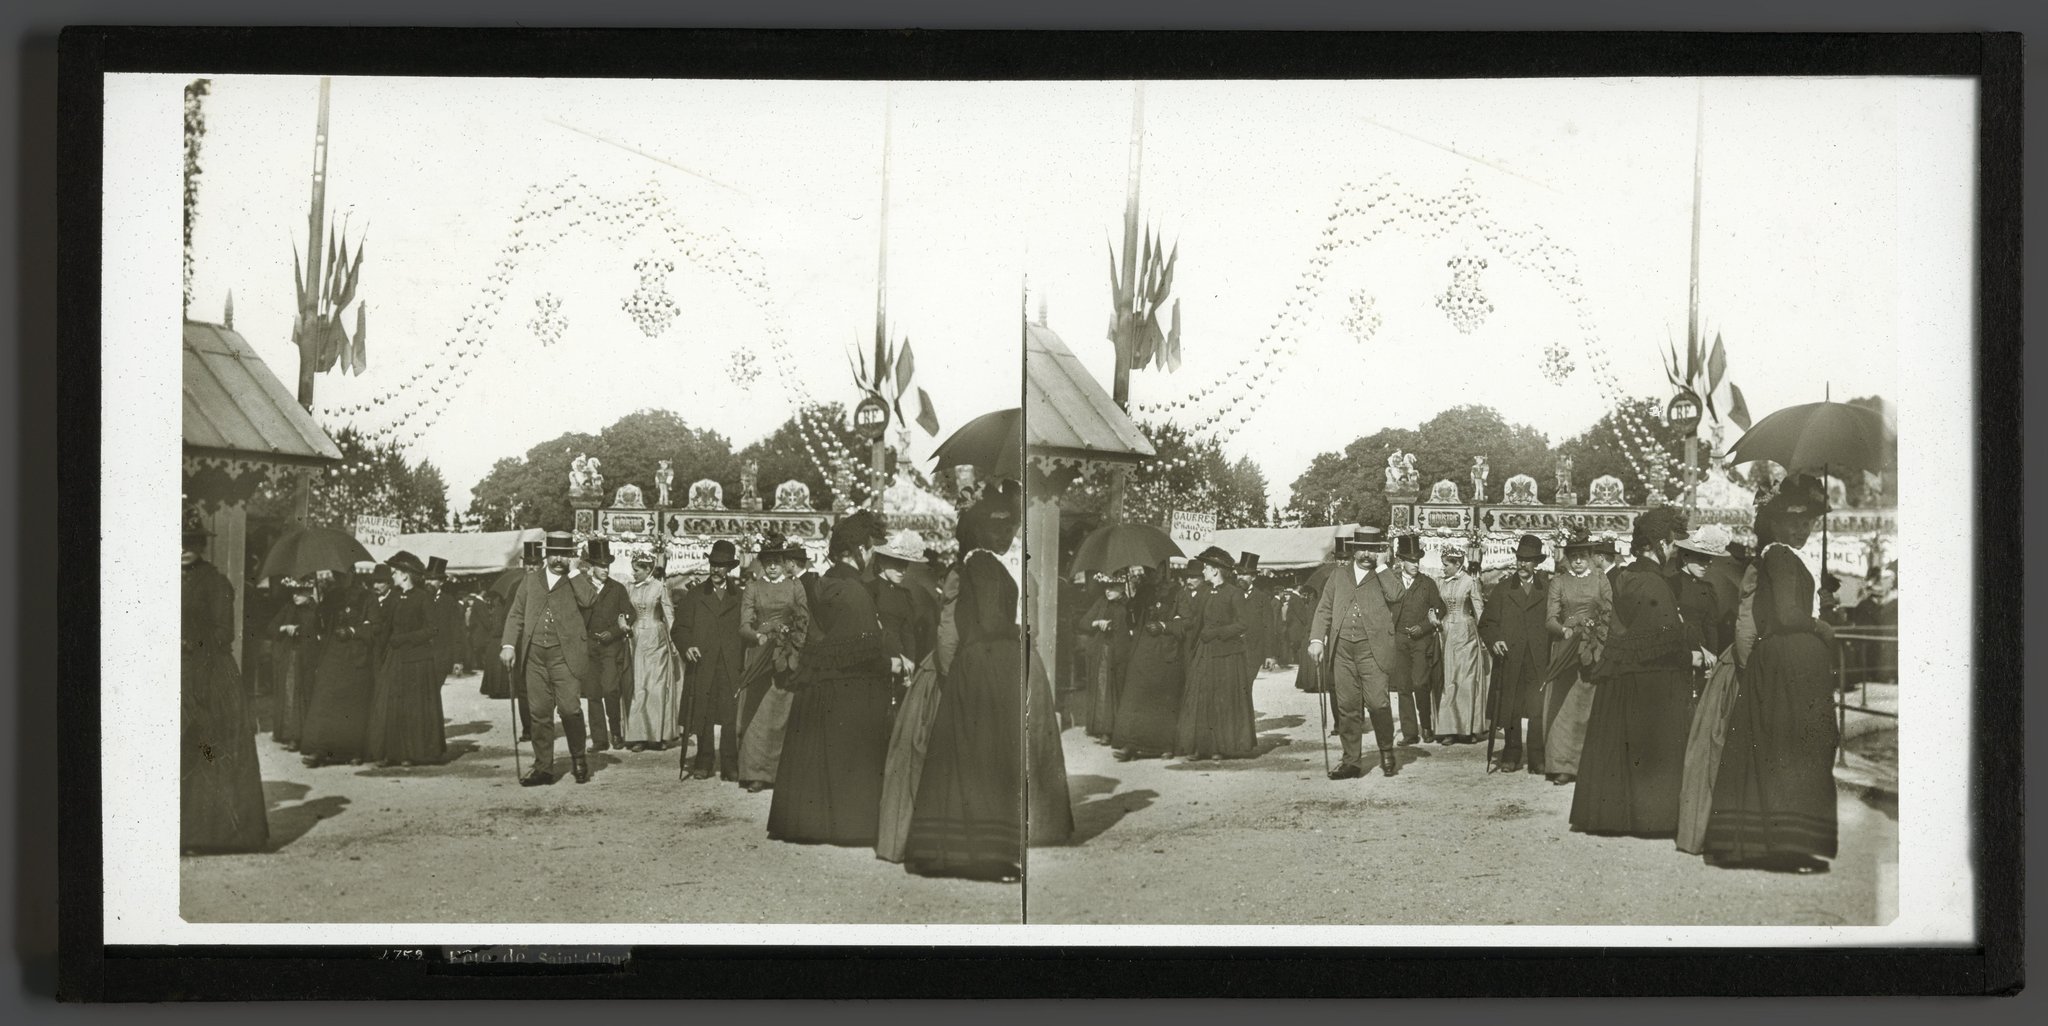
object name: stereoscopic photograph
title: Fête de Saint-Cloud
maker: Anonymous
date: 1860-1890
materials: glass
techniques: slide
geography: saint-cloud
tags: public festivities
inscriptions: number: ‘2752’